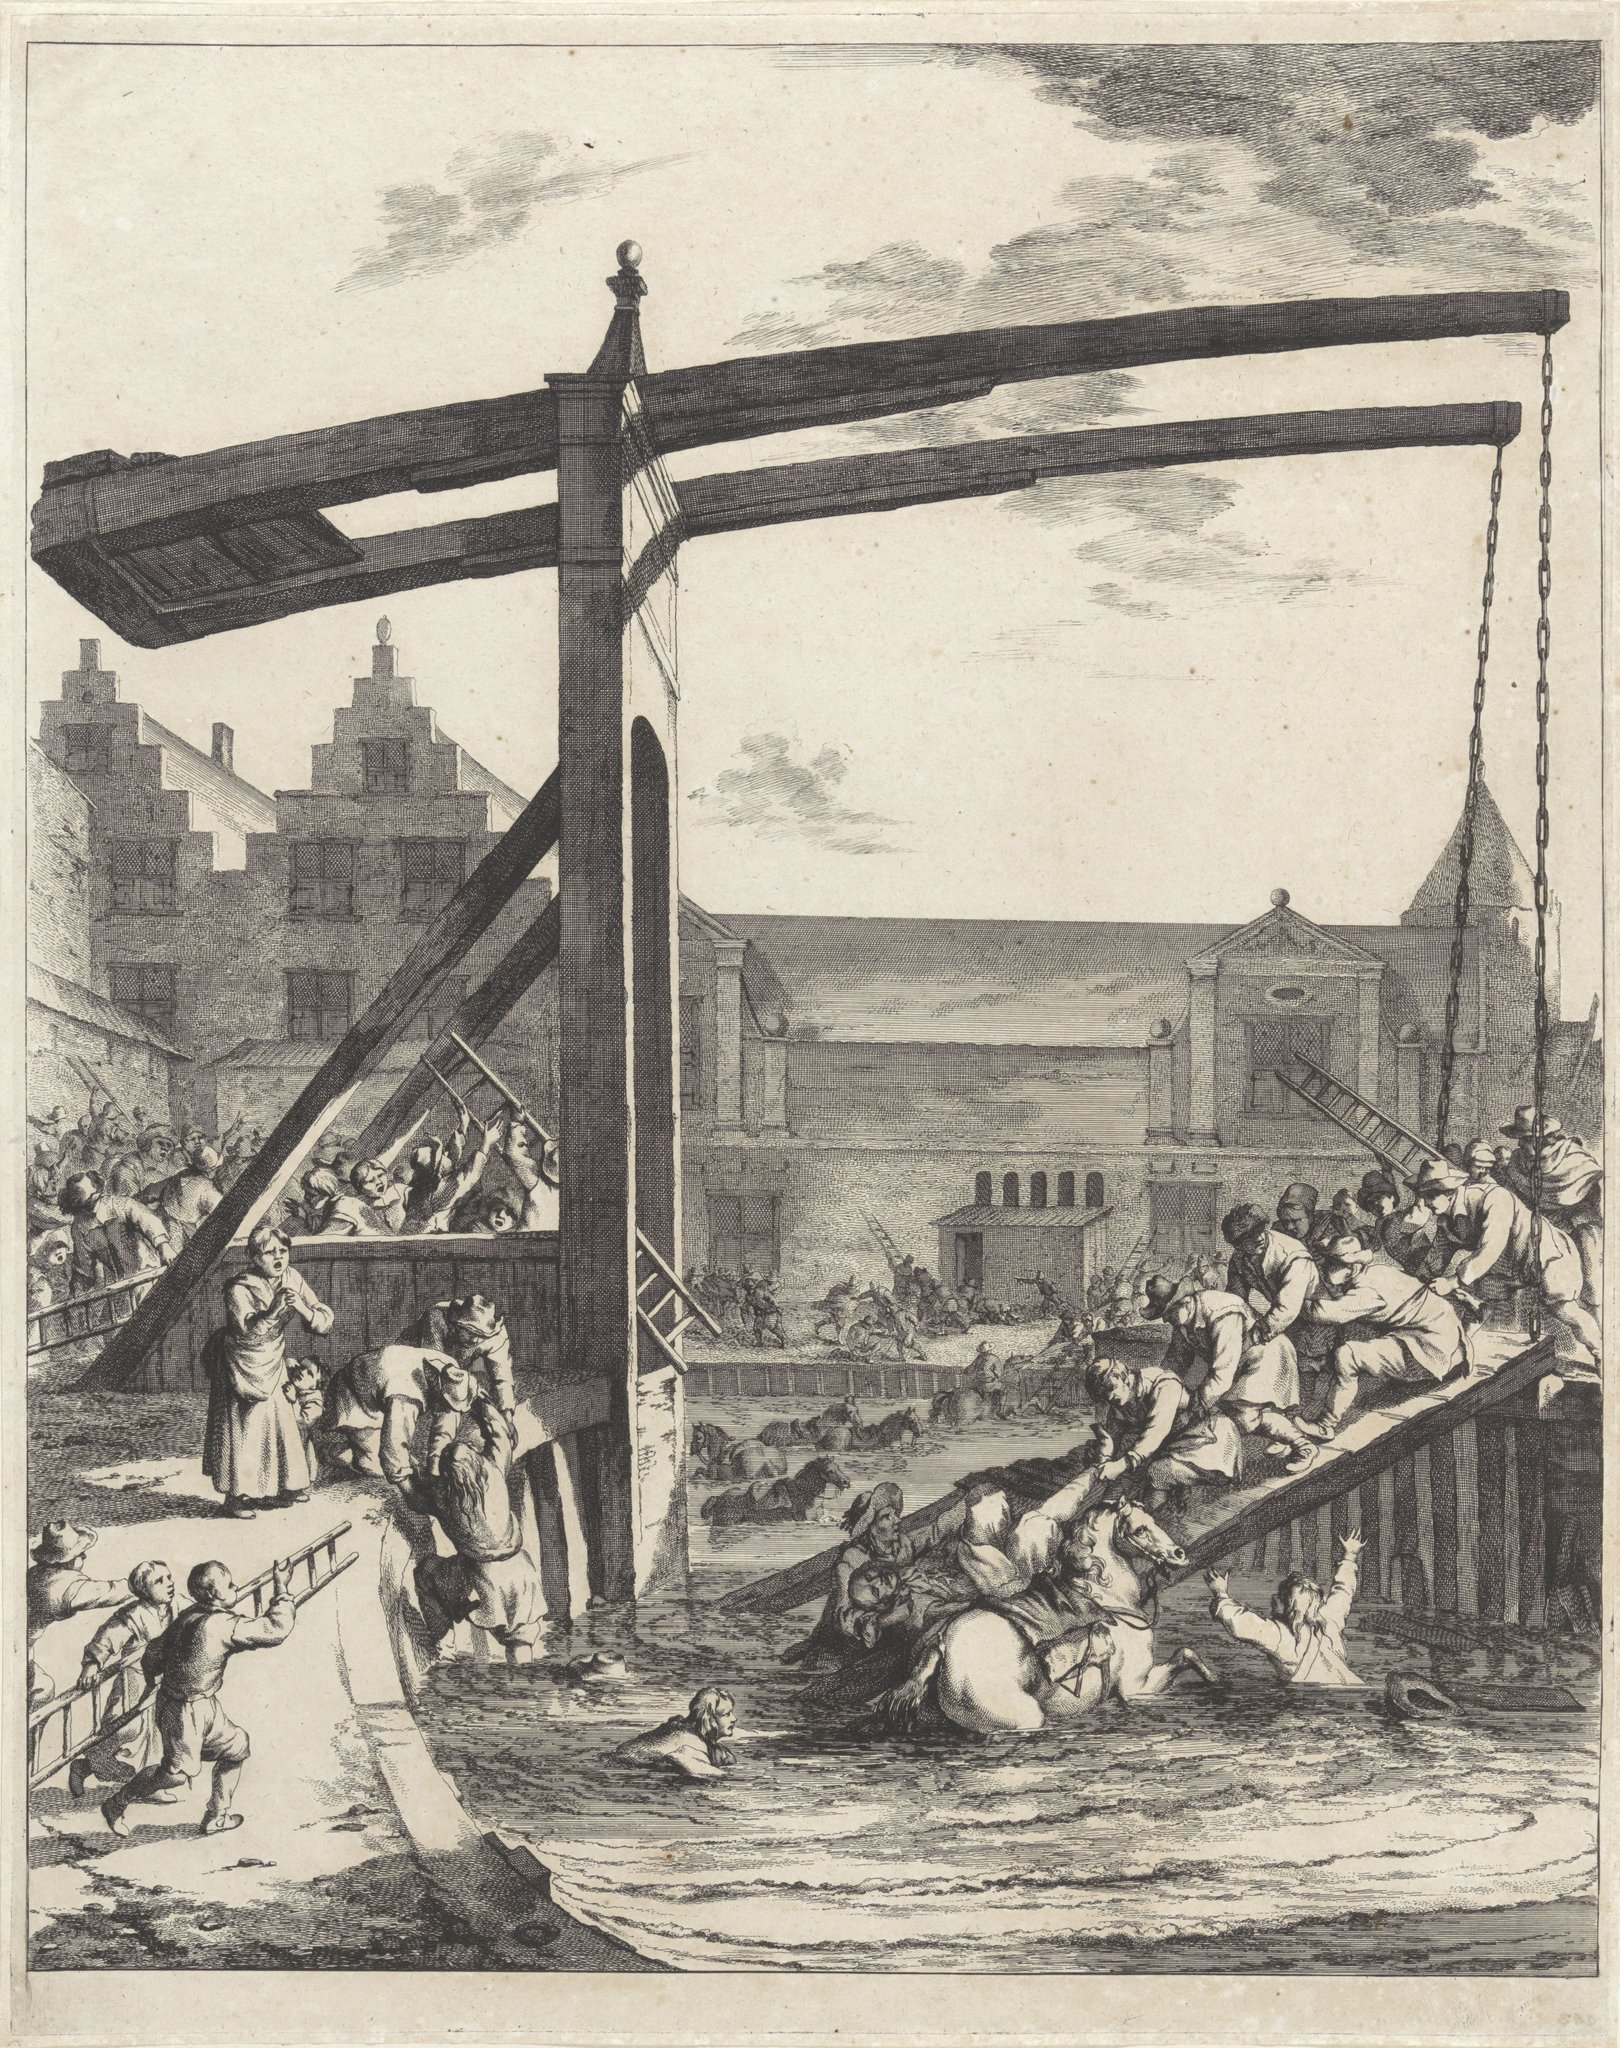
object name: print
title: Redding van graaf Johan Maurits na het ongeluk op de brug van Franeker, 1665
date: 1665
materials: paper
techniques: etching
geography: northern netherlands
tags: earl, johan maurits graaf van nassau-siegen, collapsing building, bridge, accident with horse (or kindred animal), saving a person from drowning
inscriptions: collector's mark: Lugt 240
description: Redding van graaf Johan Maurits na het ongeluk op de brug van Franeker, 1665, 6 januari 1665. De ophaalbrug waar de graaf met zijn gevolg overheen reed is ingestort. De graaf wordt uit het water gehaald, omstanders komen met ladders aangesneld.